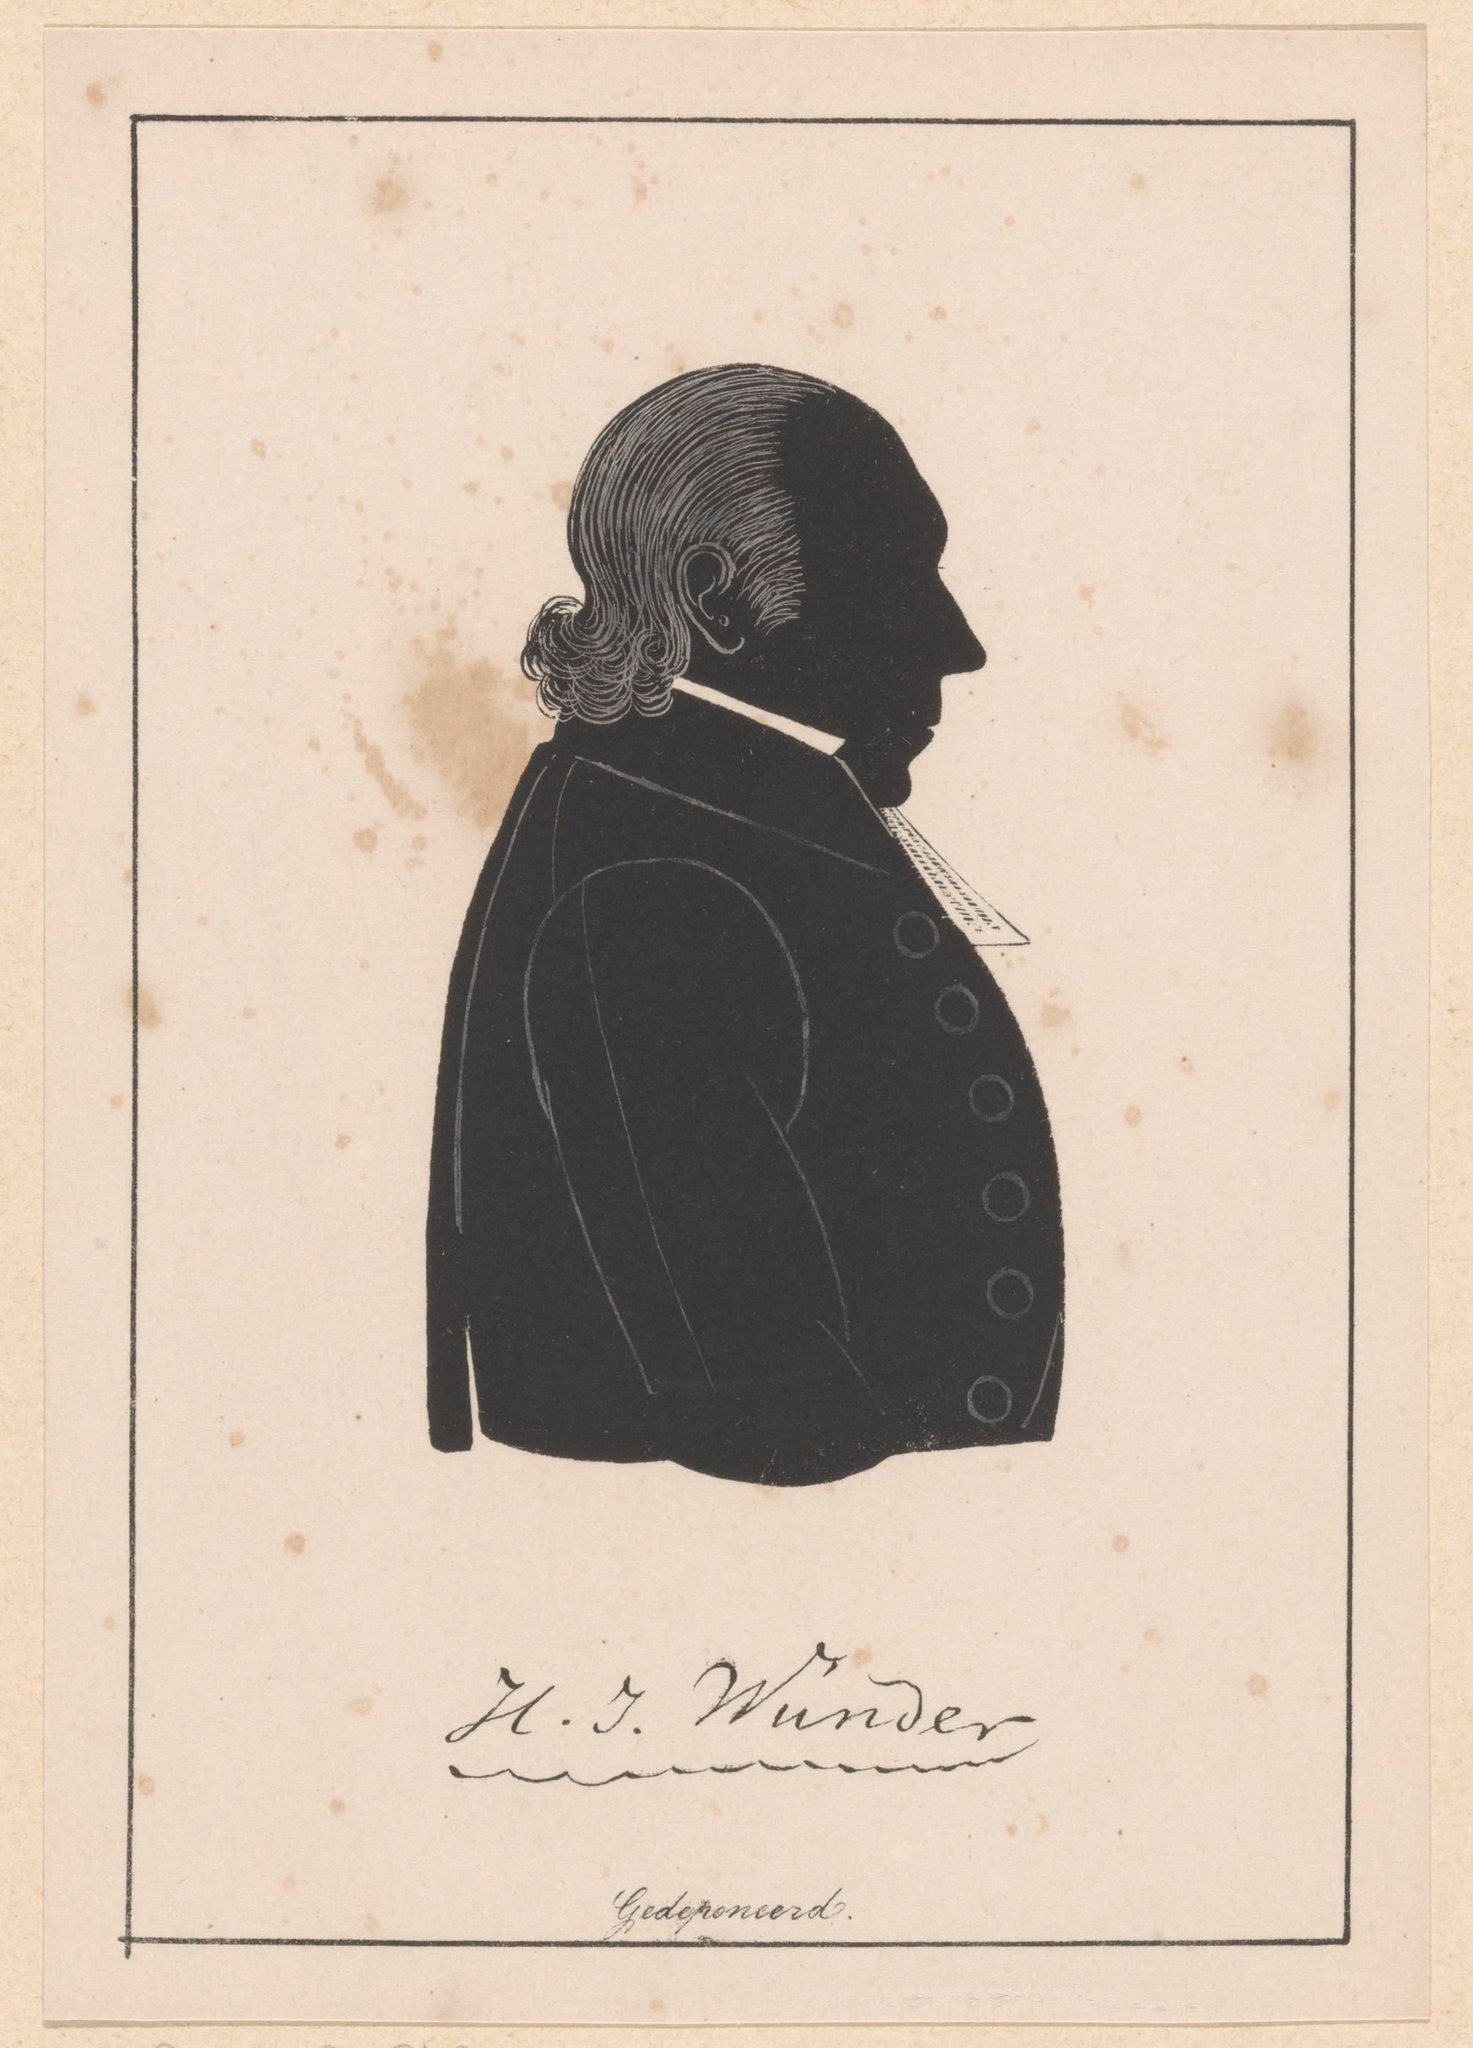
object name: print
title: Silhouetportret van Heiliger Jacob Wunder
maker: pieter barbiers (iv)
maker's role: painter, print maker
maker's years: 1798-1848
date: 1809-1848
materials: paper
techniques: hand coloring, lithograph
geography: netherlands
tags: historical persons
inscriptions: : ‘Gedeponeerd.’, collector's mark: Lugt 2228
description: Onder het portret de signatuur van de geportretteerde.